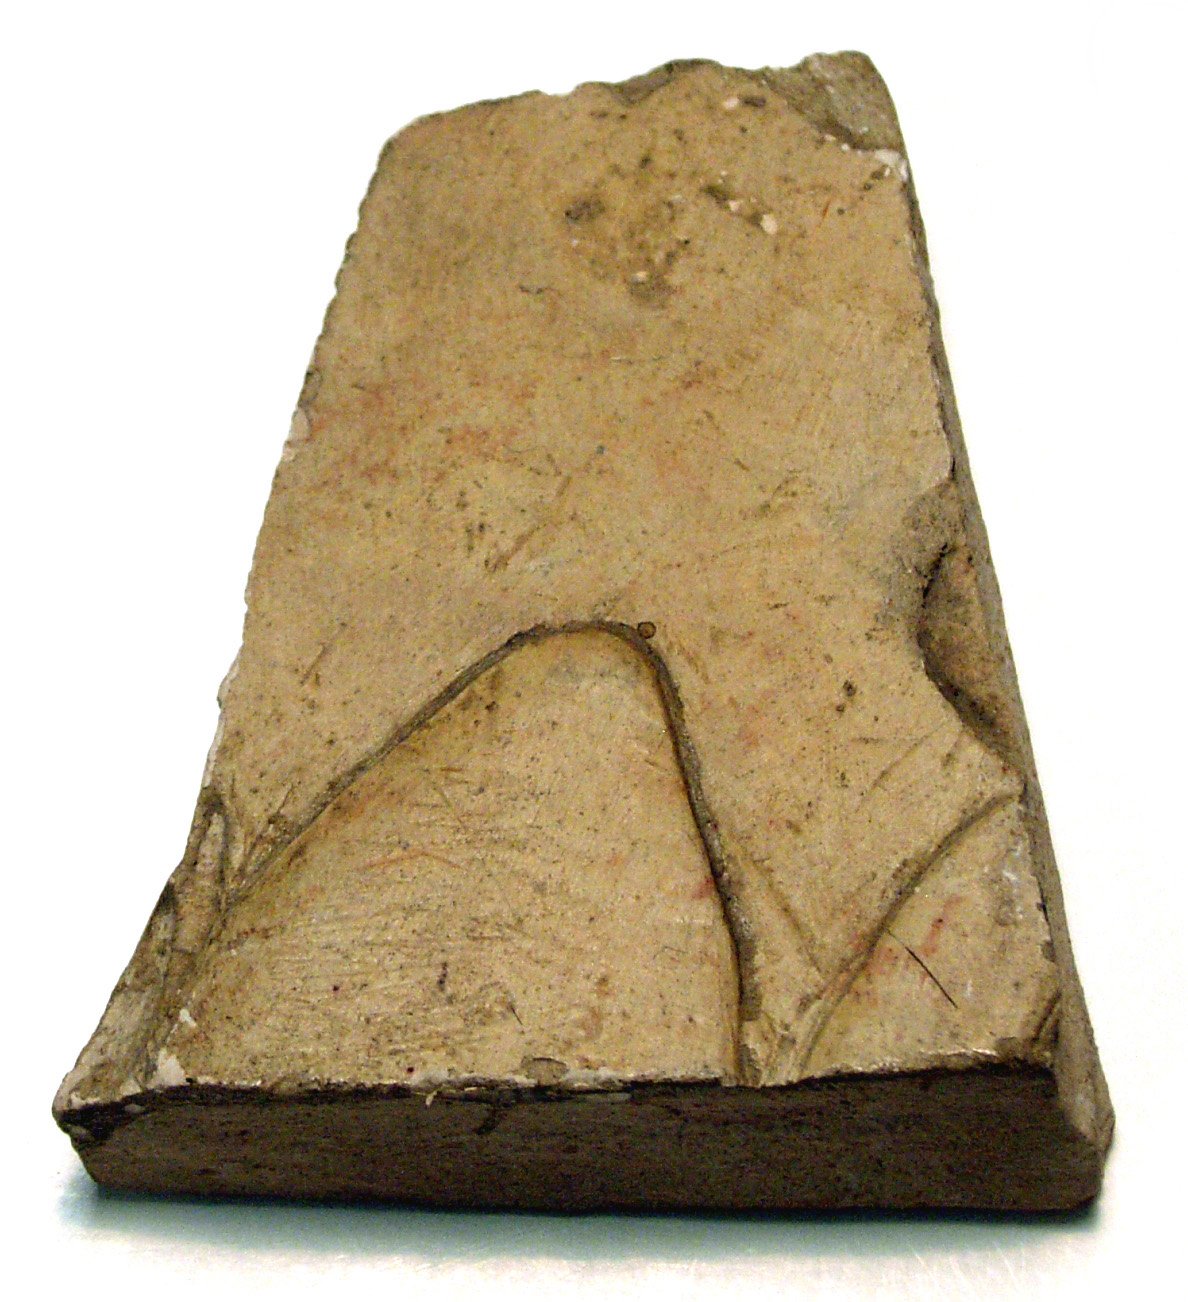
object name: relief, tomb of nespekashuty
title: Raised relief fragment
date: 664-610 BCE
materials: limestone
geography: egypt